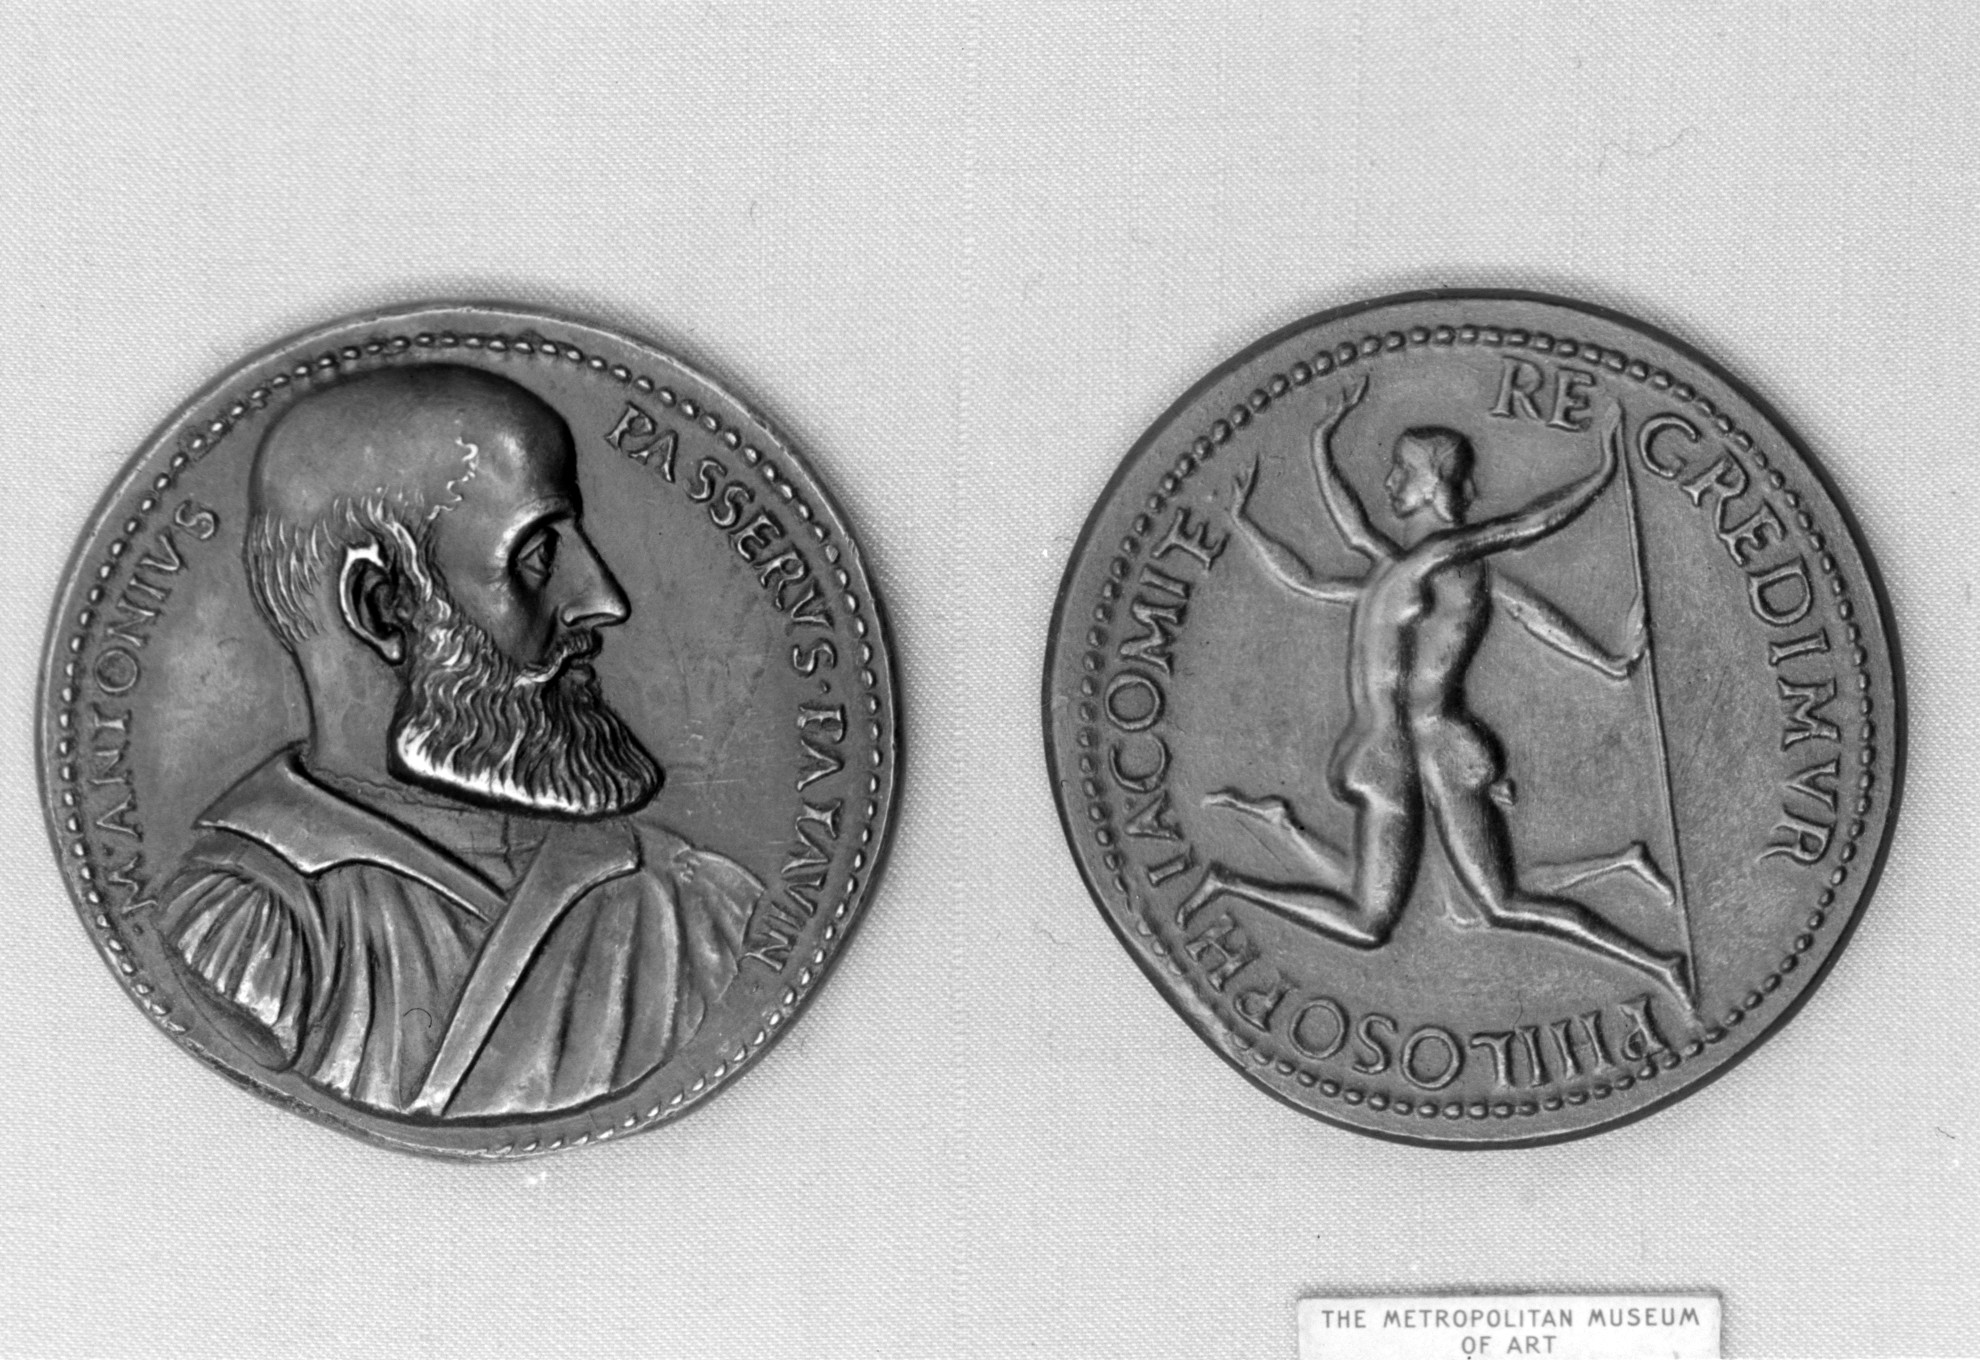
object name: medal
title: Marcantonio Passeri (1491–1565), Professor of Philosophy in the University of Padua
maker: giovanni del cavino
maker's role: artist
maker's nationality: italian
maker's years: 1500-1570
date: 1534-1566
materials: bronze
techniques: struck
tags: men,profiles